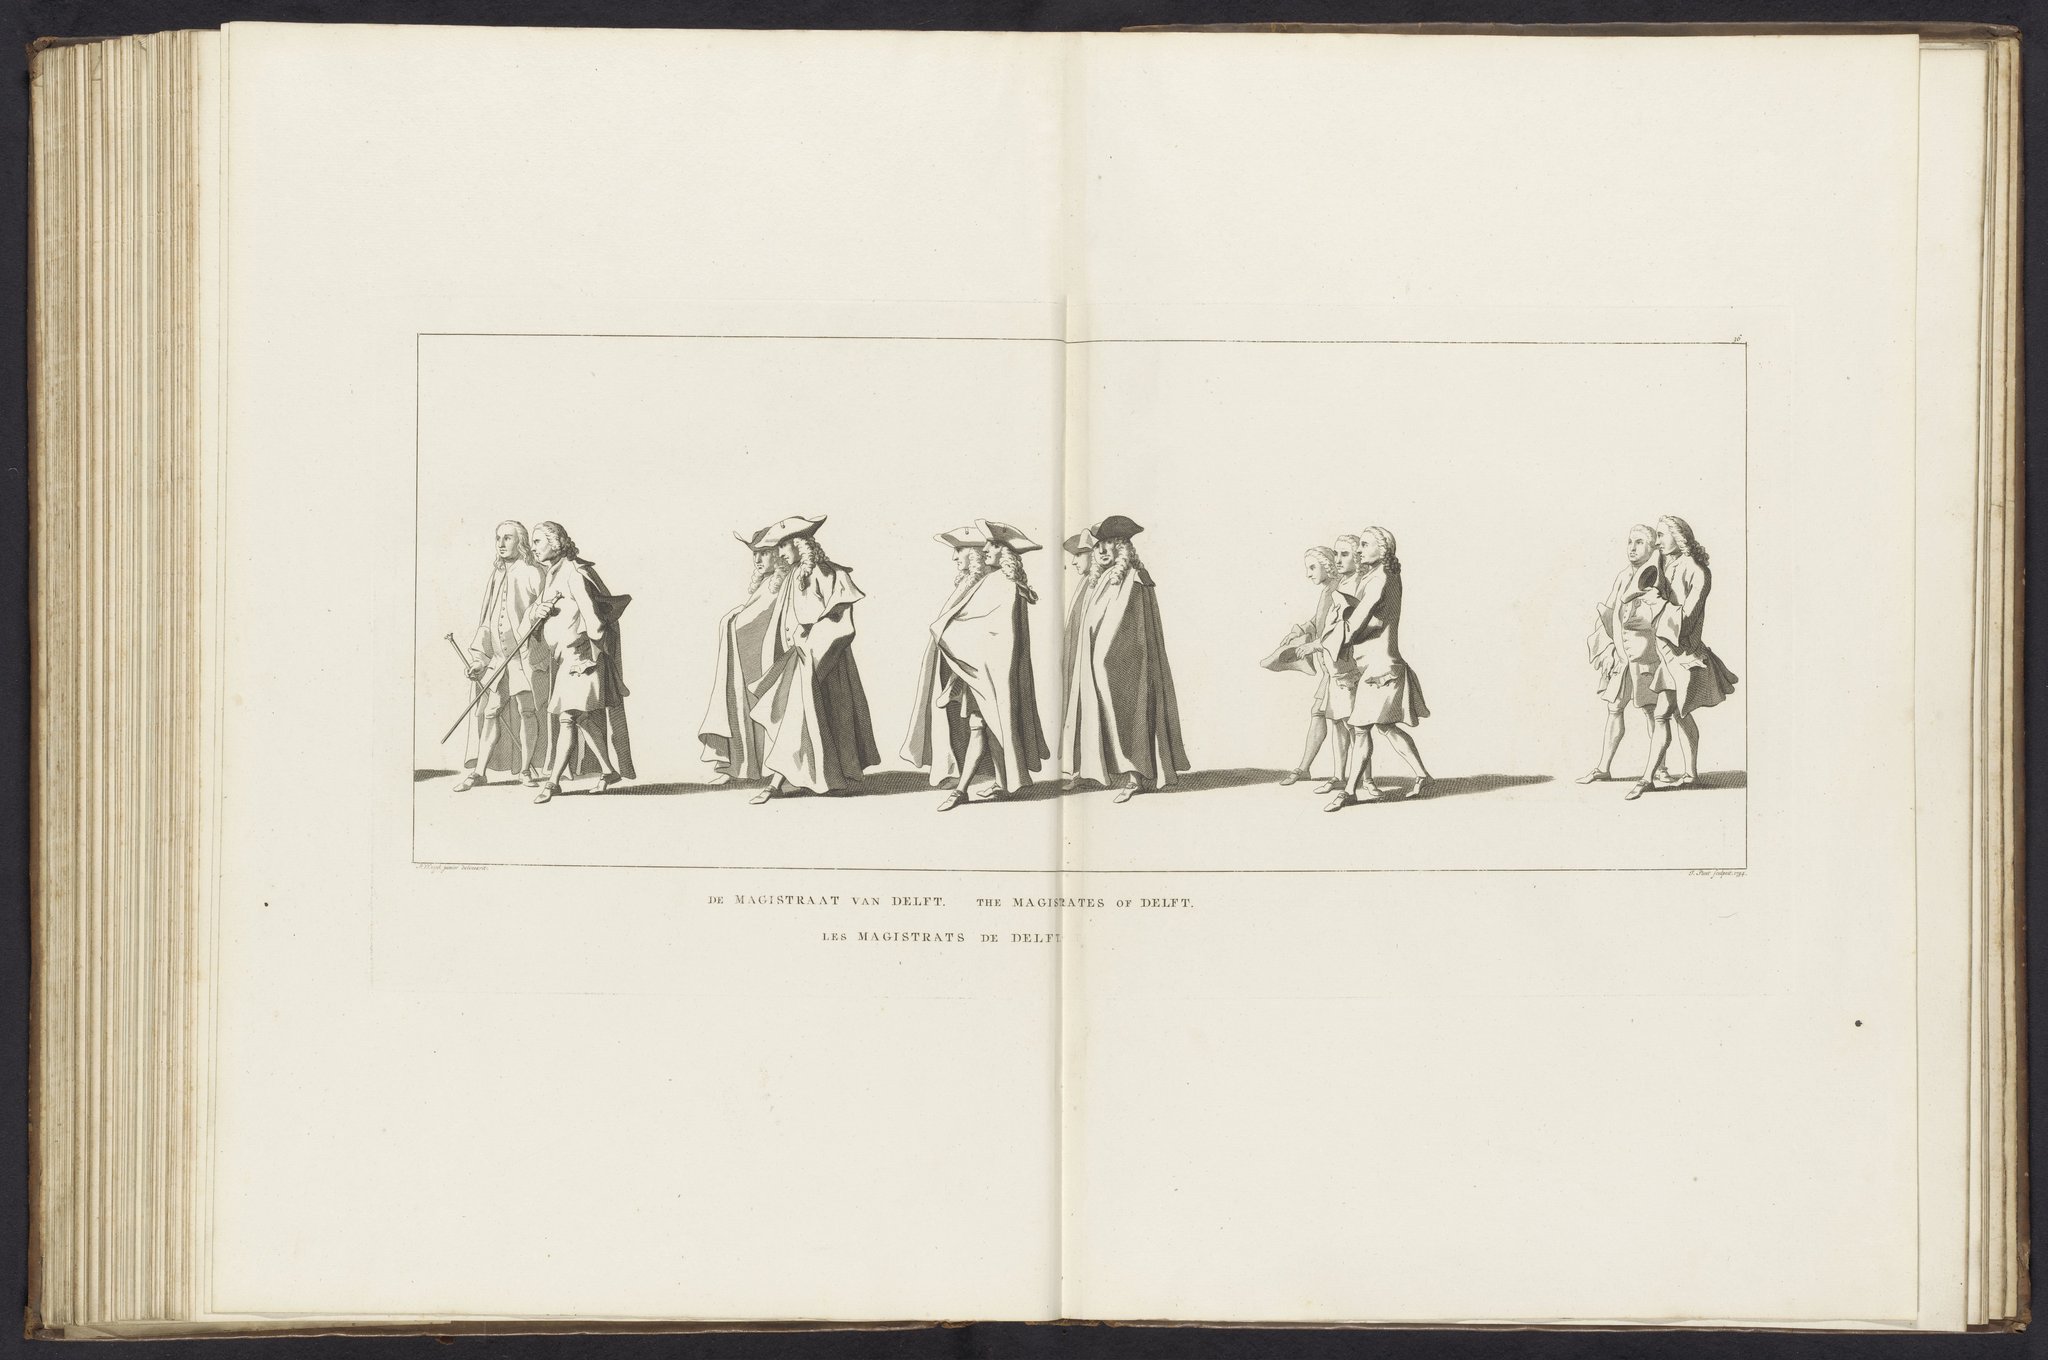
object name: print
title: Lyk-staetsie van zyne doorluchtigste Hoogheid den Heere Willem [IV] Carel Hendrik Friso, Prince van Orange en Nassau (...) gehouden den IV Februari 1752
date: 1754-1755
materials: paper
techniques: engraving, etching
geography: the hague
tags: willem iv (prins van oranje-nassau), cortege, funeral procession, municipal government, delft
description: Stadsbestuur van Delft. In de marge het onderschrift in Nederlands, Frans en Engels. Onderdeel van een serie van 41 platen van de begrafenisstoet van stadhouder Willem IV te Delft op 4 februari 1752. Genummerd rechtsboven: 36. In de gebonden uitgave van 1755.